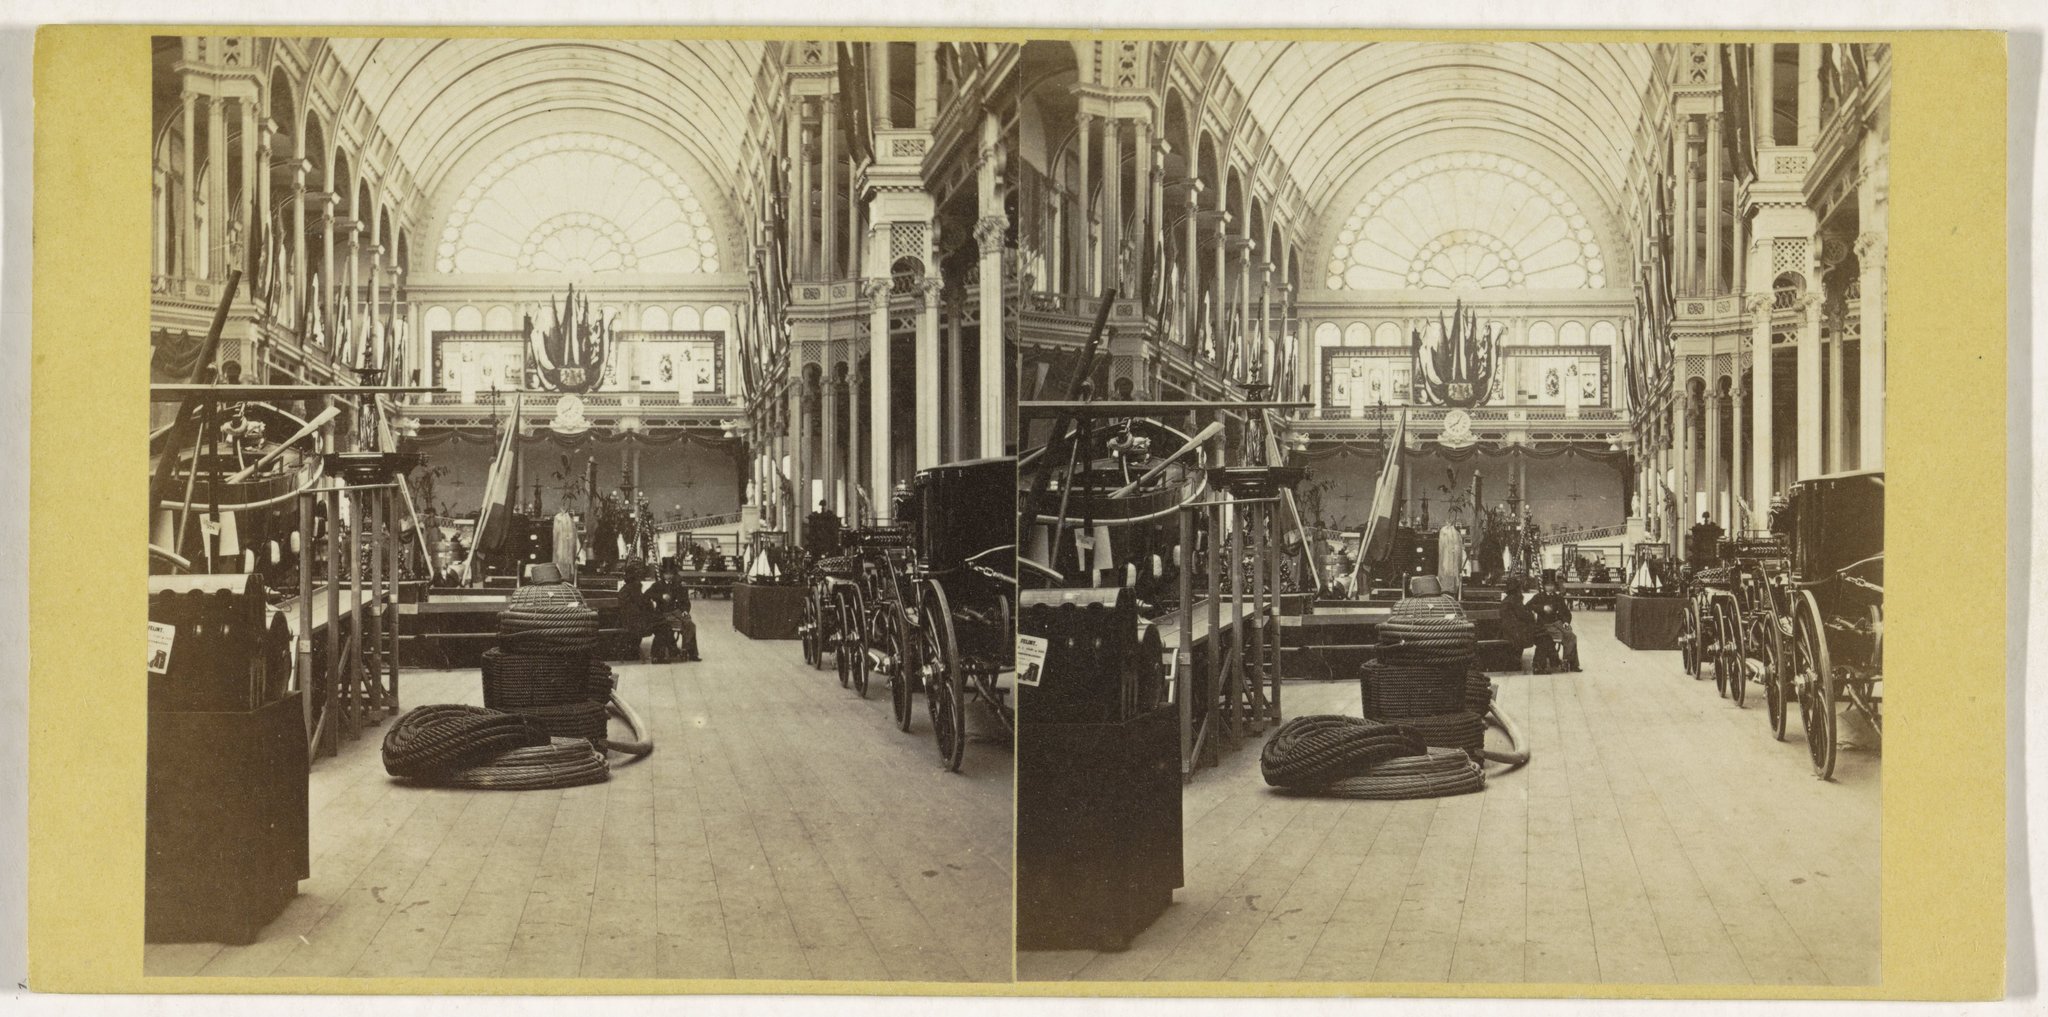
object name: stereograph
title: Boot en koetsen bij de Tentoonstelling voor Nationale Nijverheid en Kunst in het Paleis voor Volksvlijt, Amsterdam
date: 1866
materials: cardboard, paper, photographic support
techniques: albumen print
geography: amsterdam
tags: amsterdam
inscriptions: label: ‘Boek & Kunsthandel Jan D. Brouwer, Kalverstraat E, Nº 37 Amsterdam.’, stamp: ‘JDB’